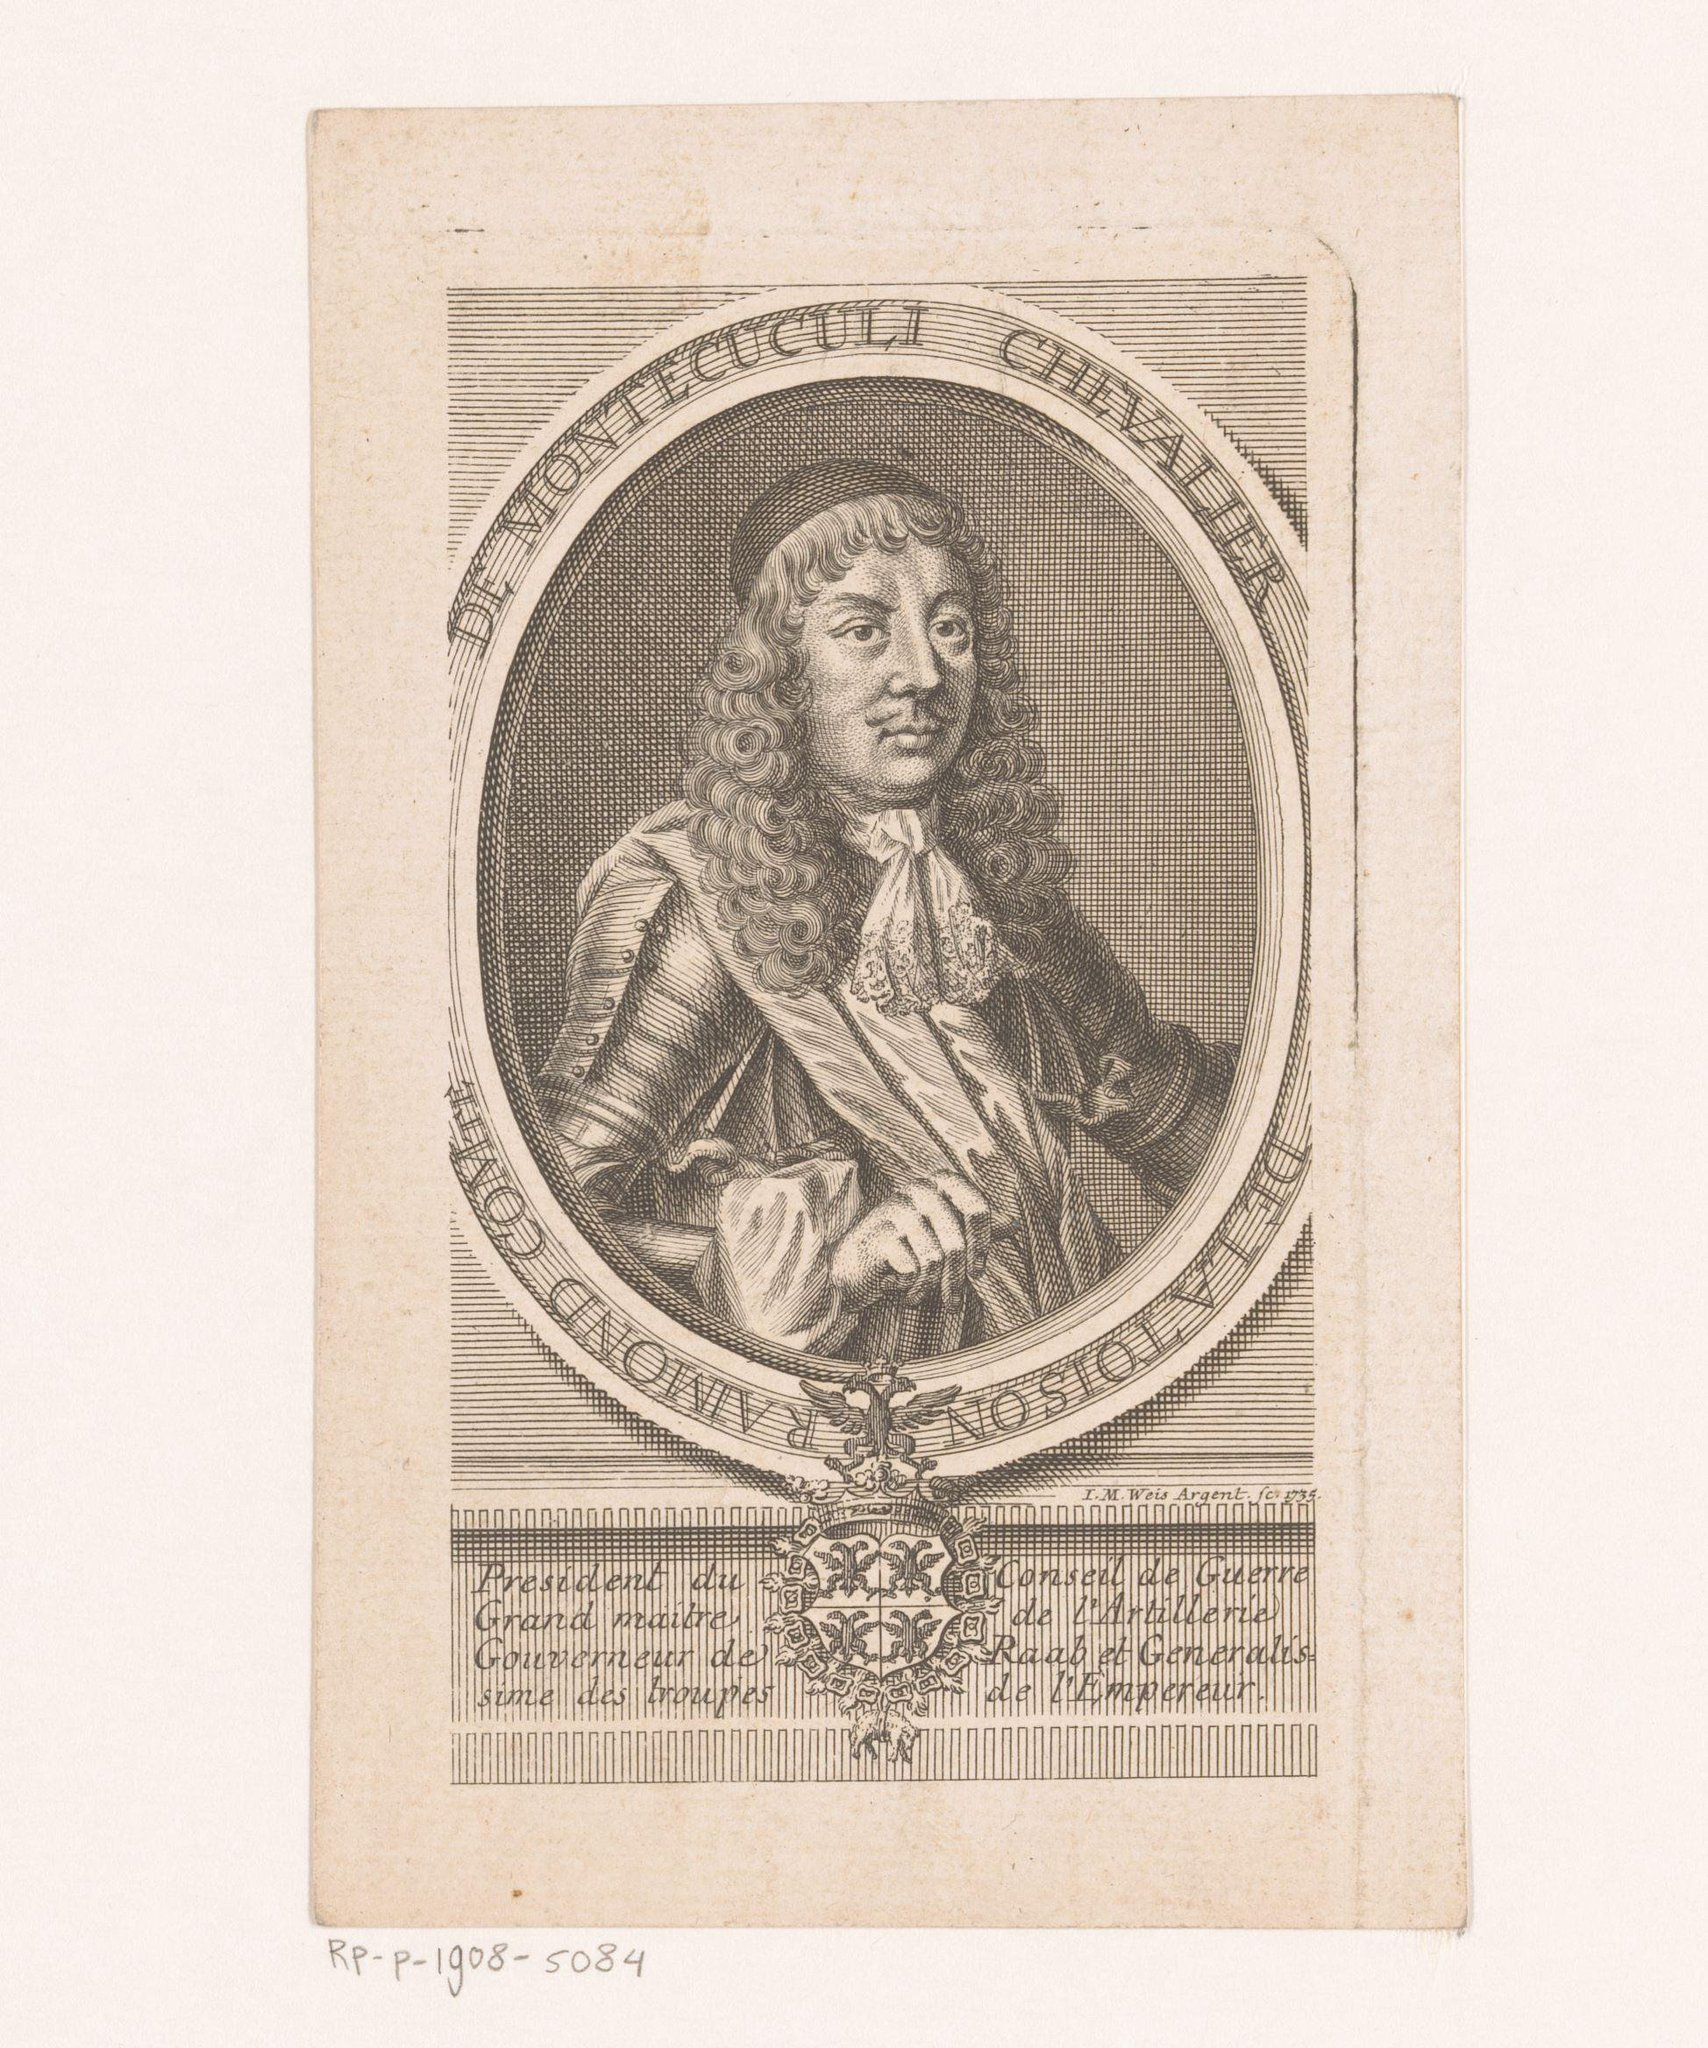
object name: print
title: Portret van Raimund, Fürst von Montecuccoli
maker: johann martin weis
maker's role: designer, draughtsman, print maker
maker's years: 1711-1751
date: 1735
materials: paper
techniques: engraving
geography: straatsburg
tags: historical persons, knighthood order of the golden fleece - insignia of a knighthood order, e.g.: badge, chain (with name of order)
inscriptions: collector's mark: Lugt 2228